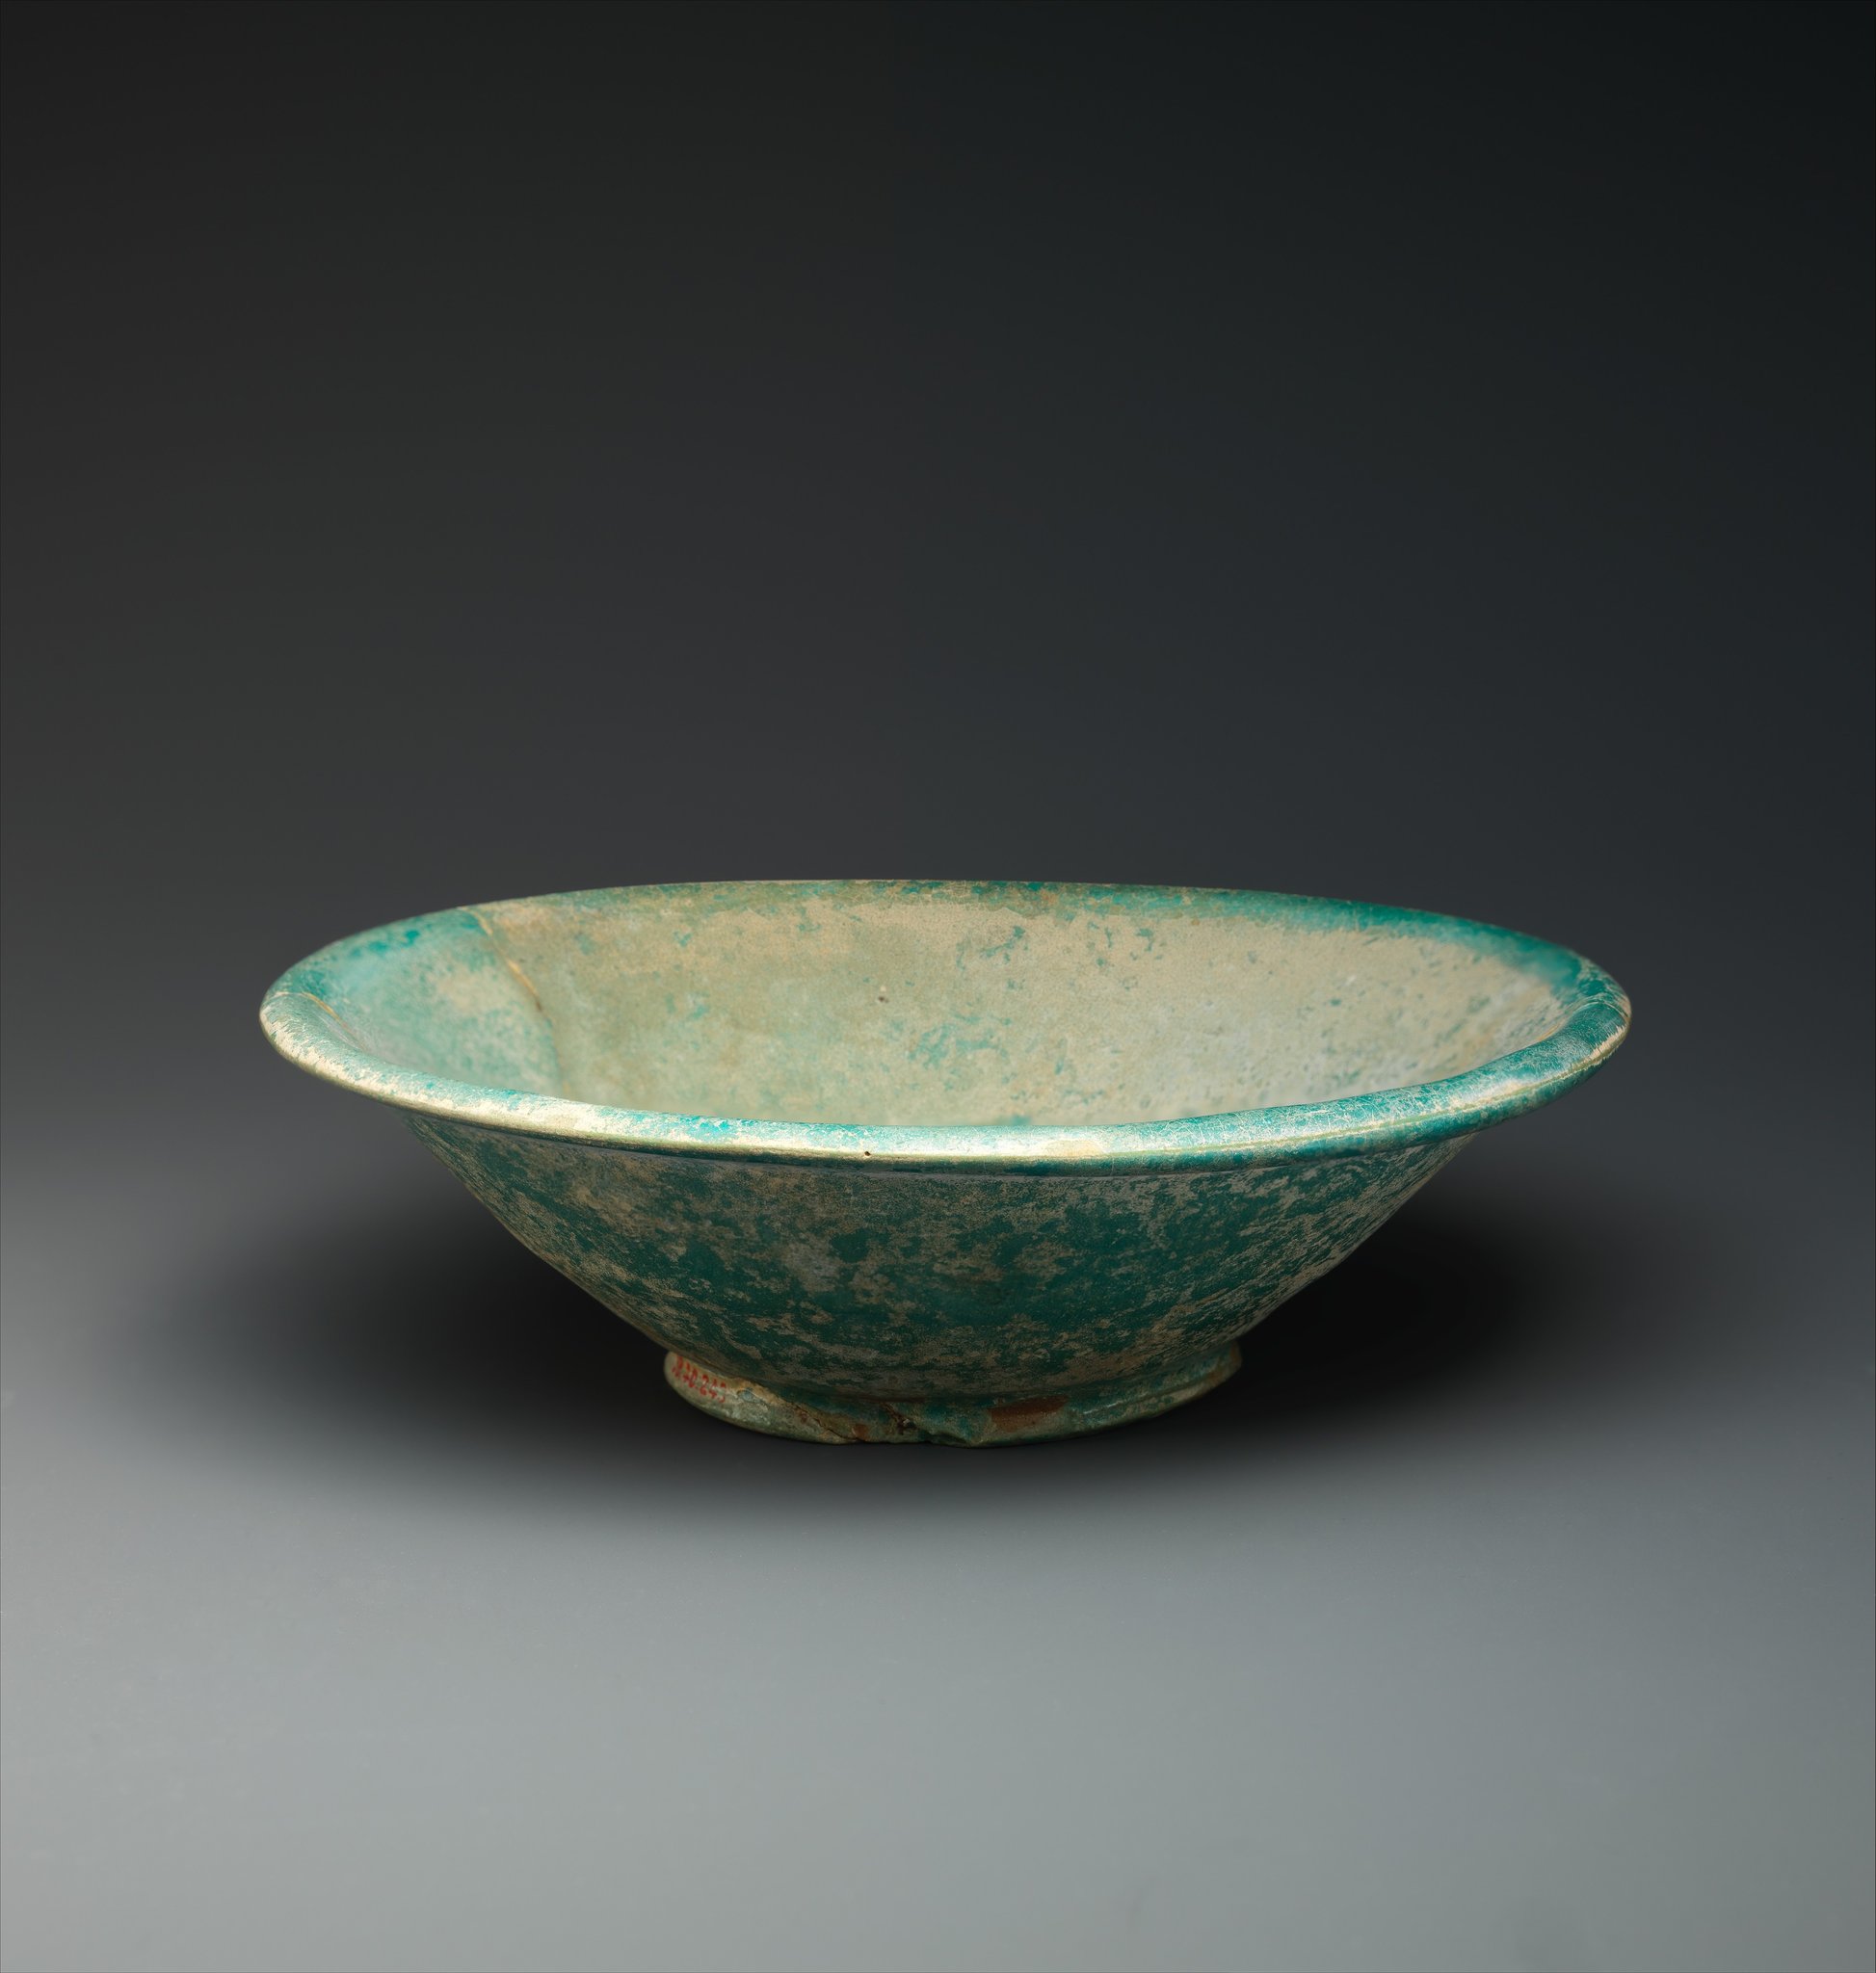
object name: bowl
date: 901-1000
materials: earthenware, glaze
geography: iran